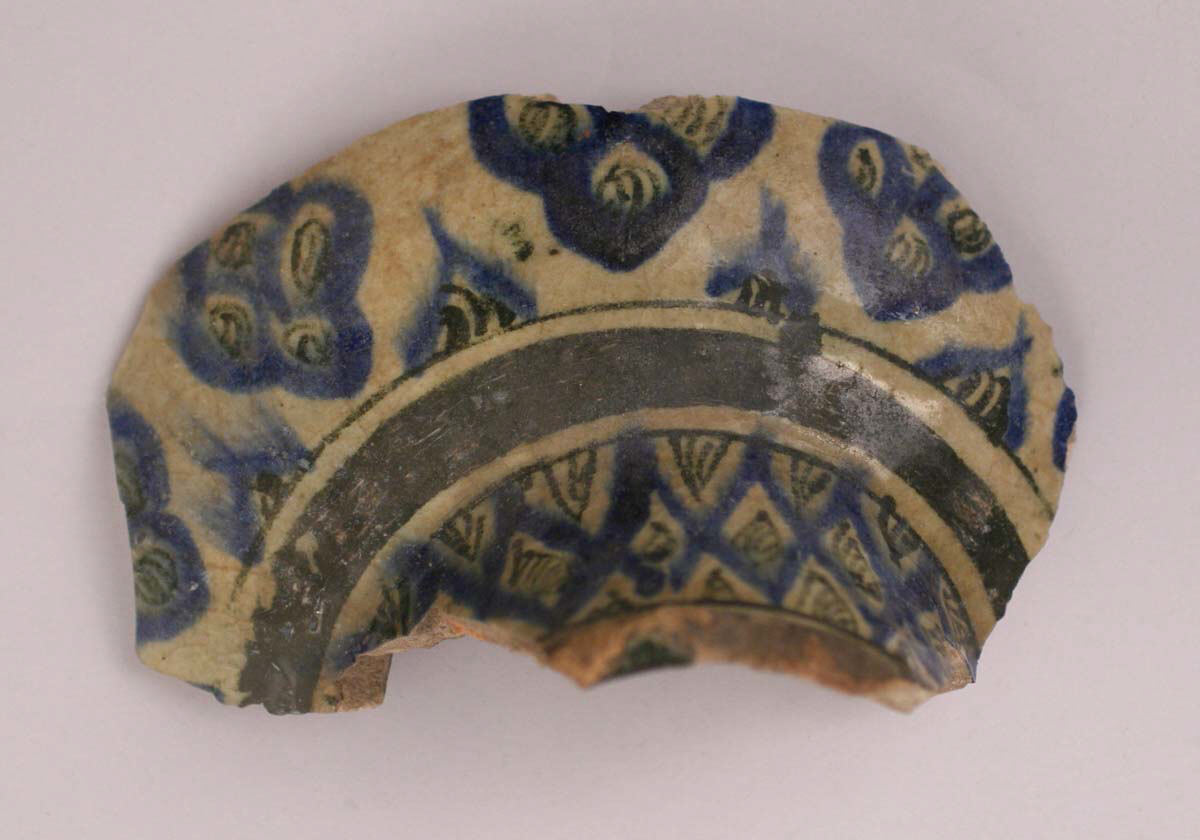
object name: ceramic fragment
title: Fragment of Bottle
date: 1301-1500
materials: glaze, stonepaste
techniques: painting, polychrome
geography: egypt or syria